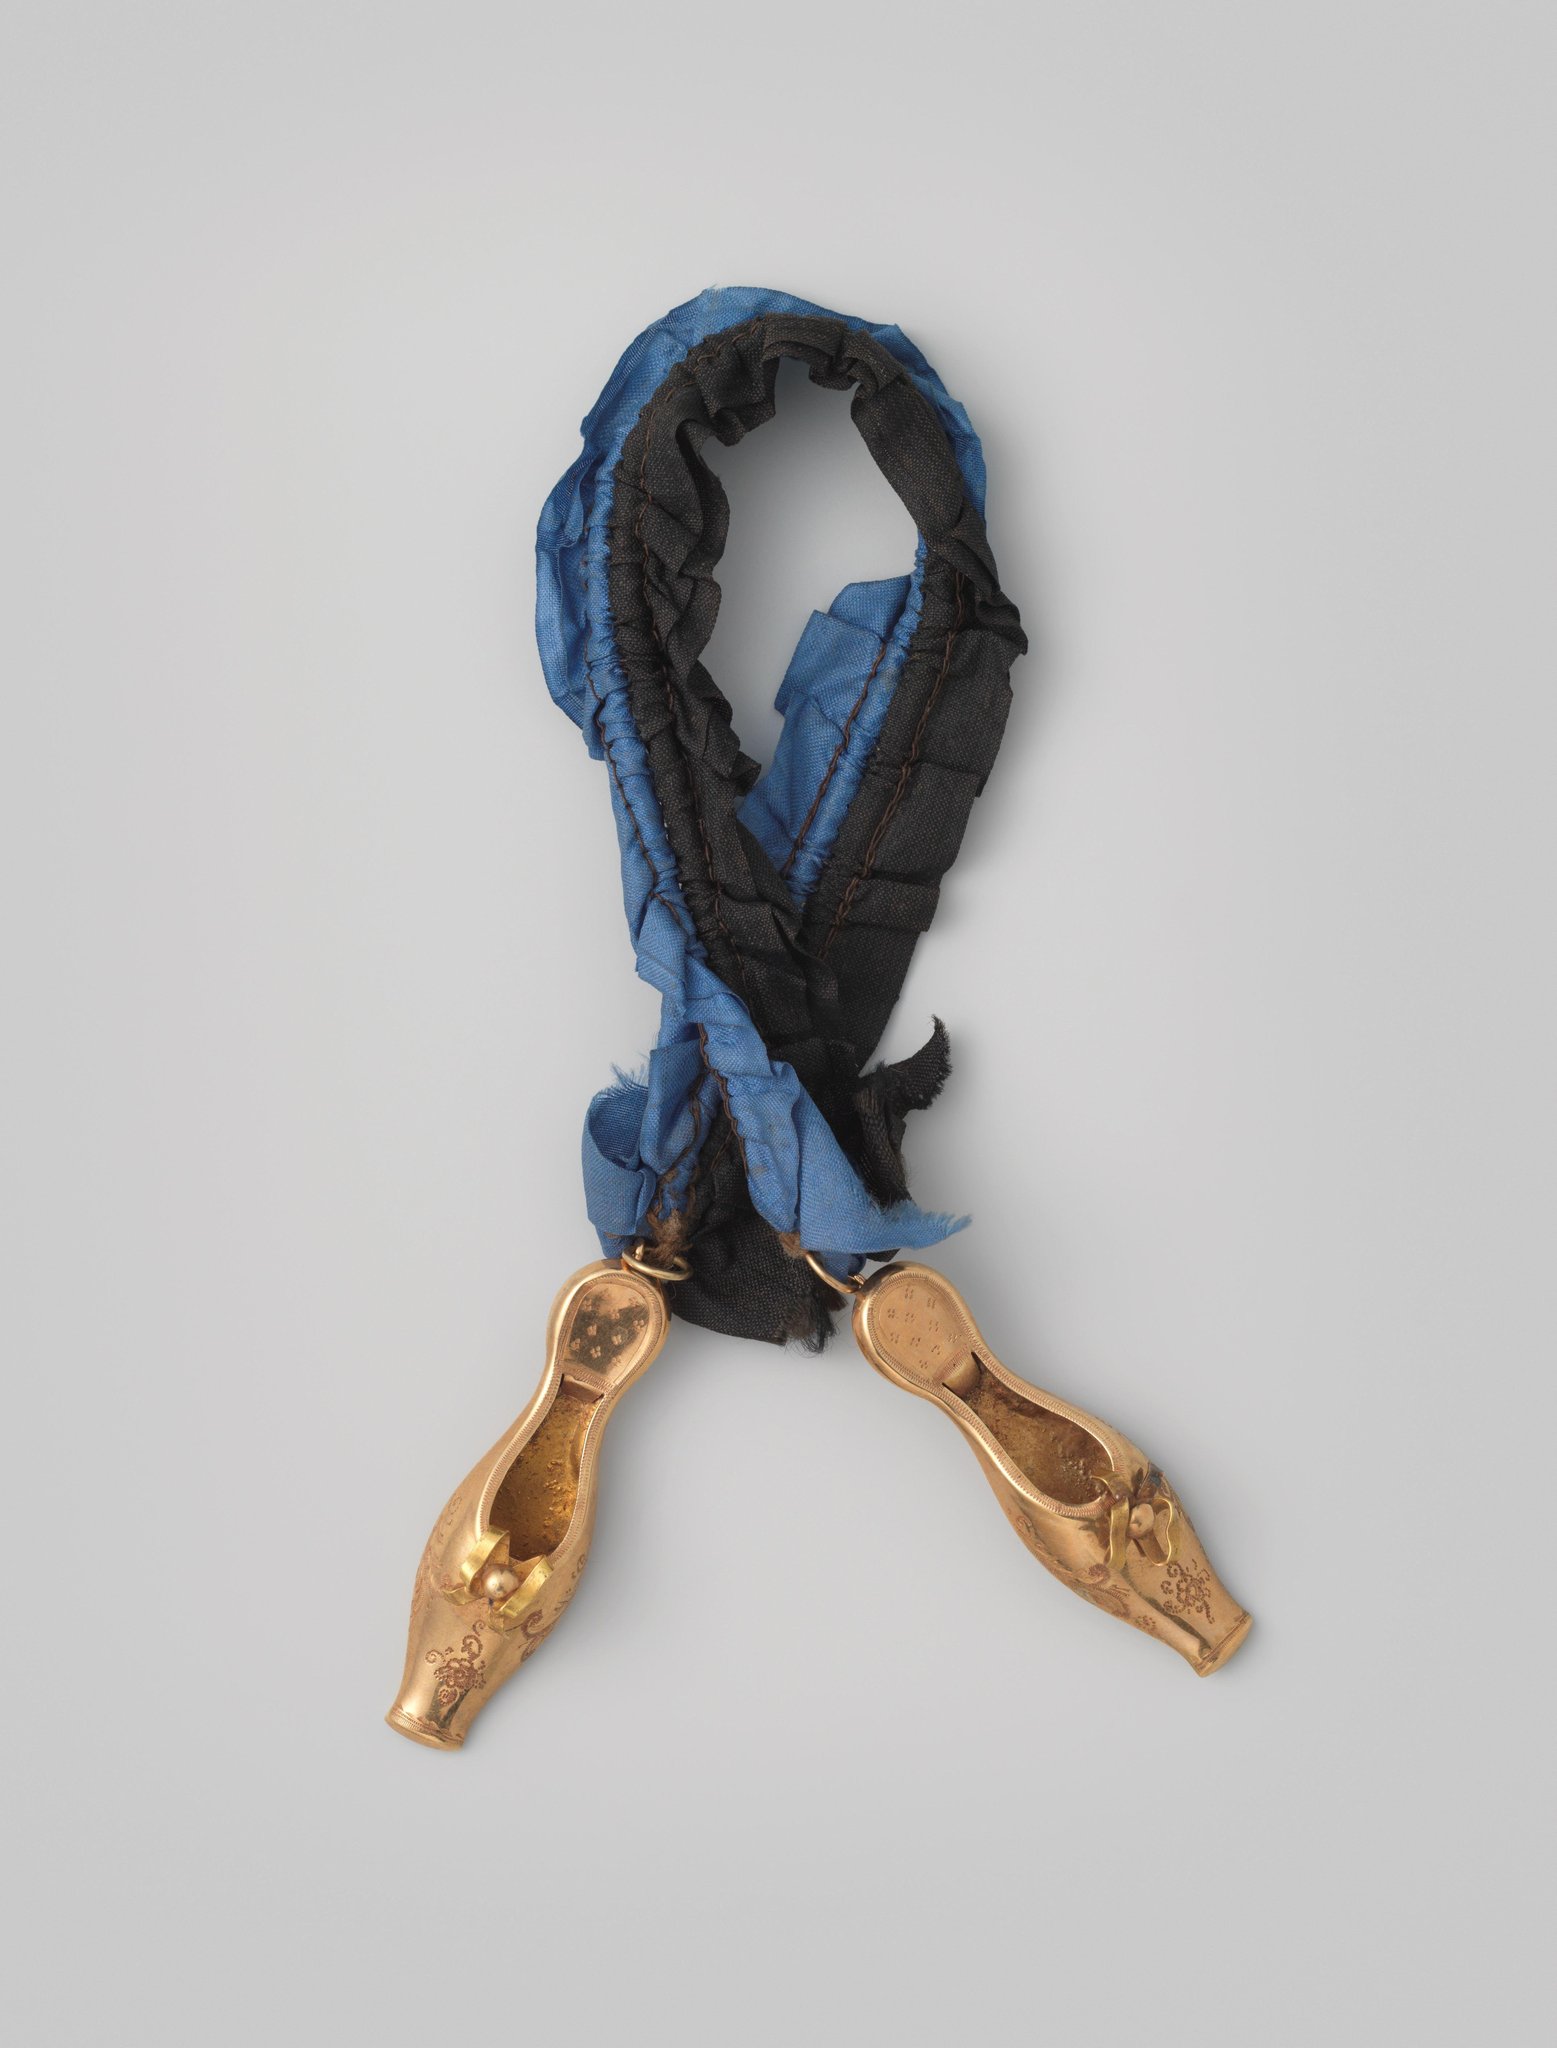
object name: breinaalddop, breidop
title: Breinaalddoppen van goud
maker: Anonymous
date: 1850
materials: gold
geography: netherlands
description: Breinaalddoppen van goud, bestaande uit twee muiltjes van goud verbonden door zwarte en blauwe linten, waarin elastieken.